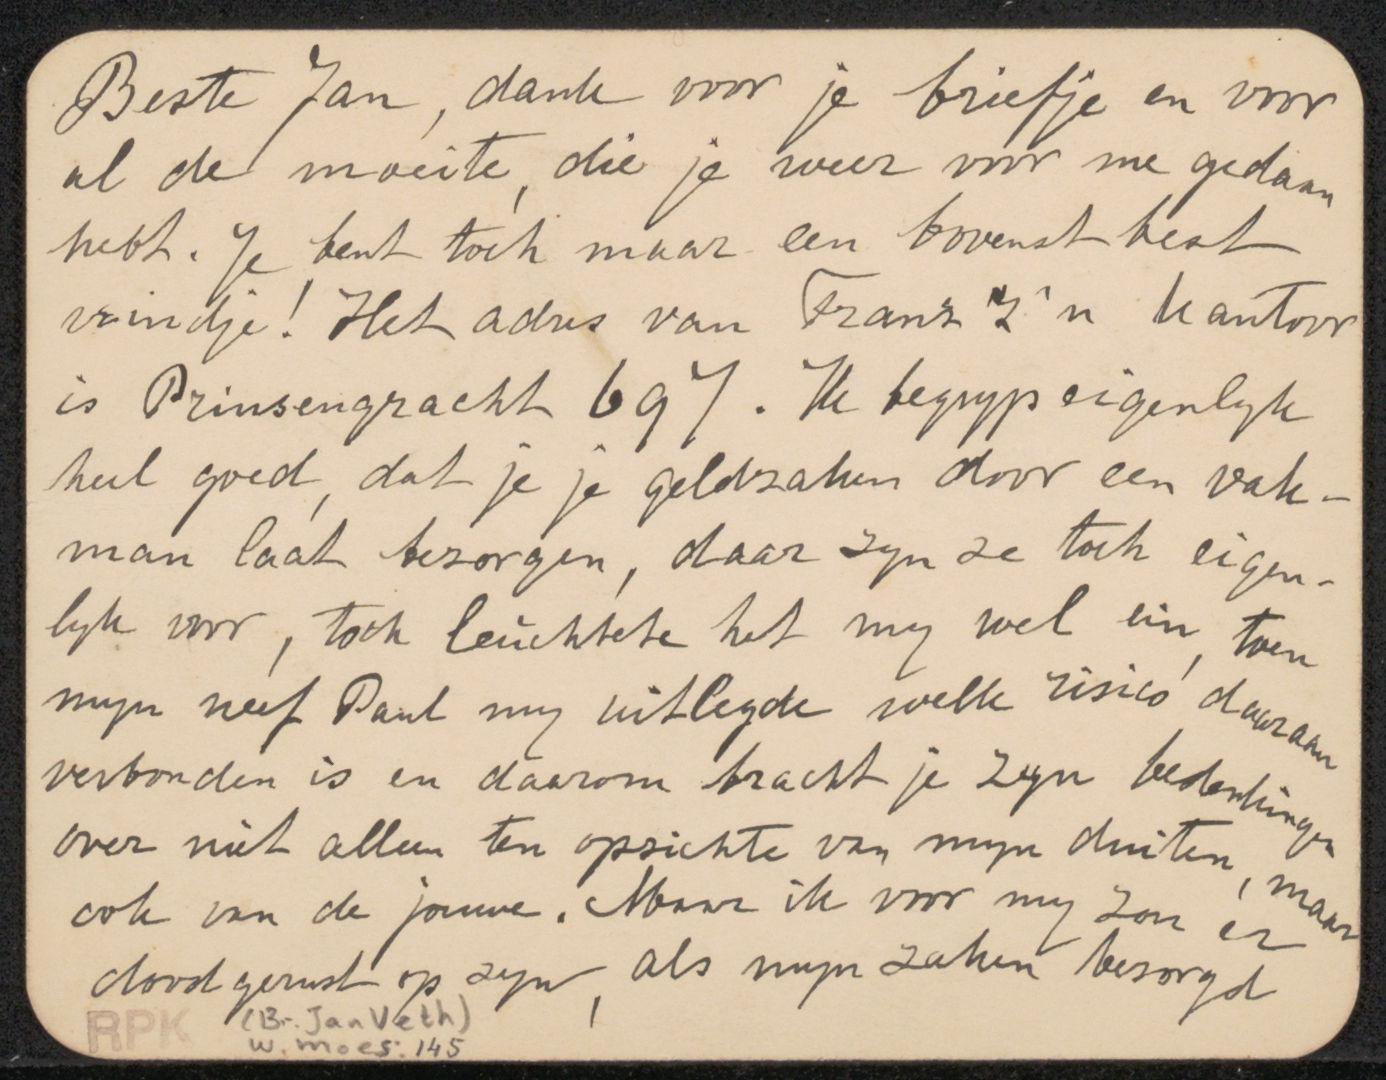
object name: letter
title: Brief aan Jan Veth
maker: wally moes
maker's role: draughtsman, print maker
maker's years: 1856-1918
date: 1874-1918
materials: ink, paper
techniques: pen, writing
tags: dordrecht, painter, print maker, draughtsman, designer, jan veth, literature ~ arts, diseases, money, germany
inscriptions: collector's mark: ‘RPK’